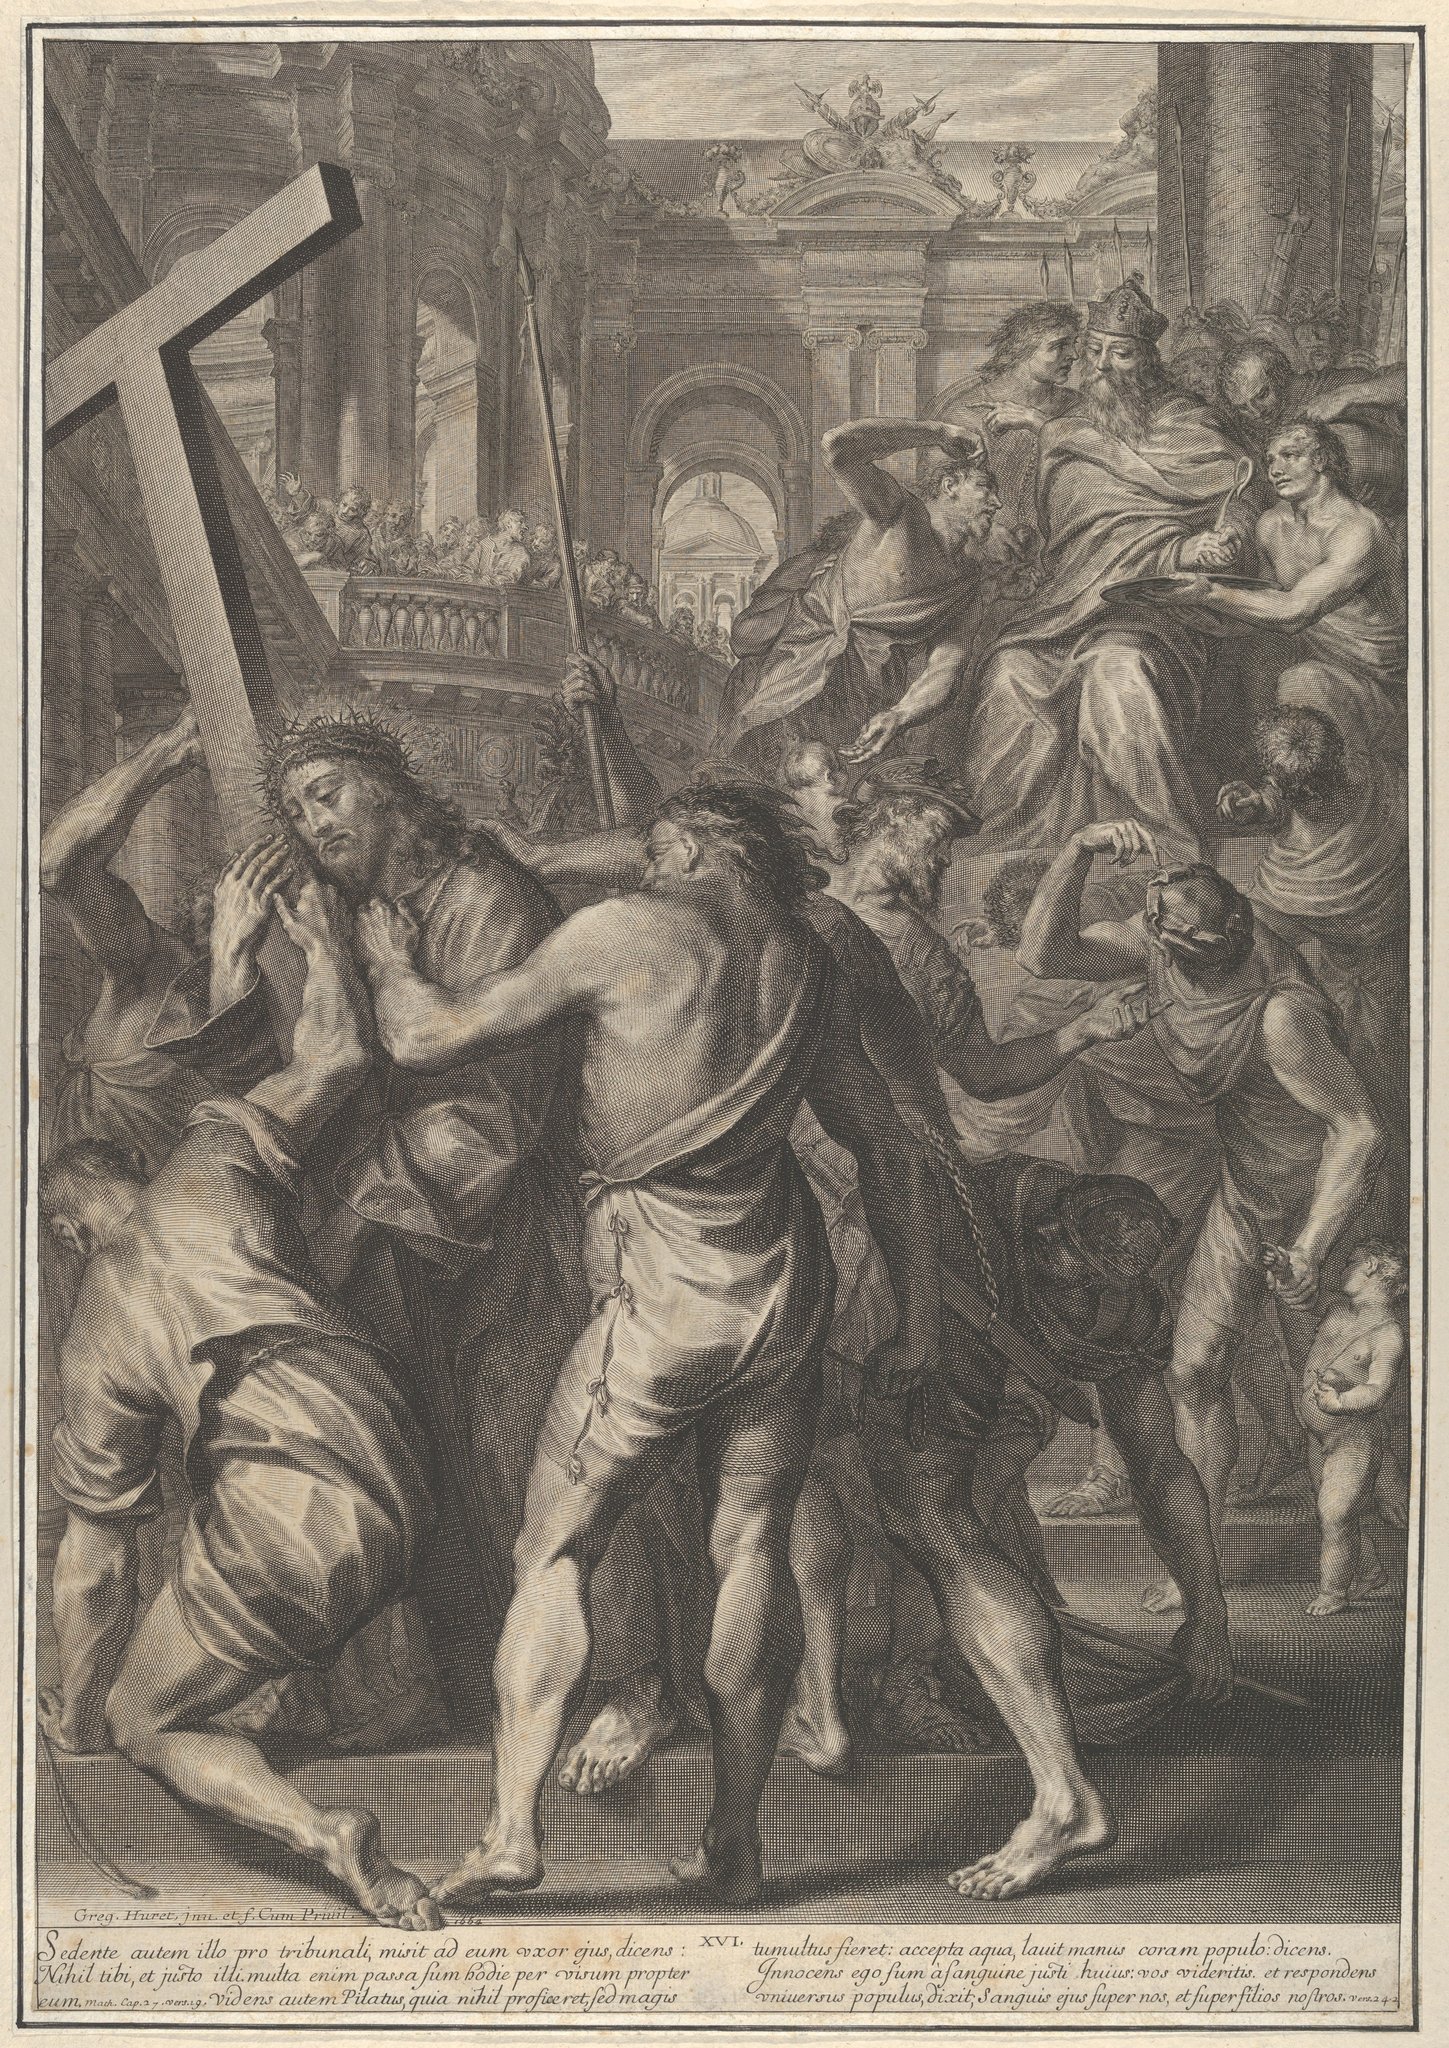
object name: print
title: Christ is Sentenced by Pilate, from The Passion of Christ, plate 16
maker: grégoire huret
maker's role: artist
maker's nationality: french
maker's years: 1606-1670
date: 1664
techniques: engraving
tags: men,christ,cross